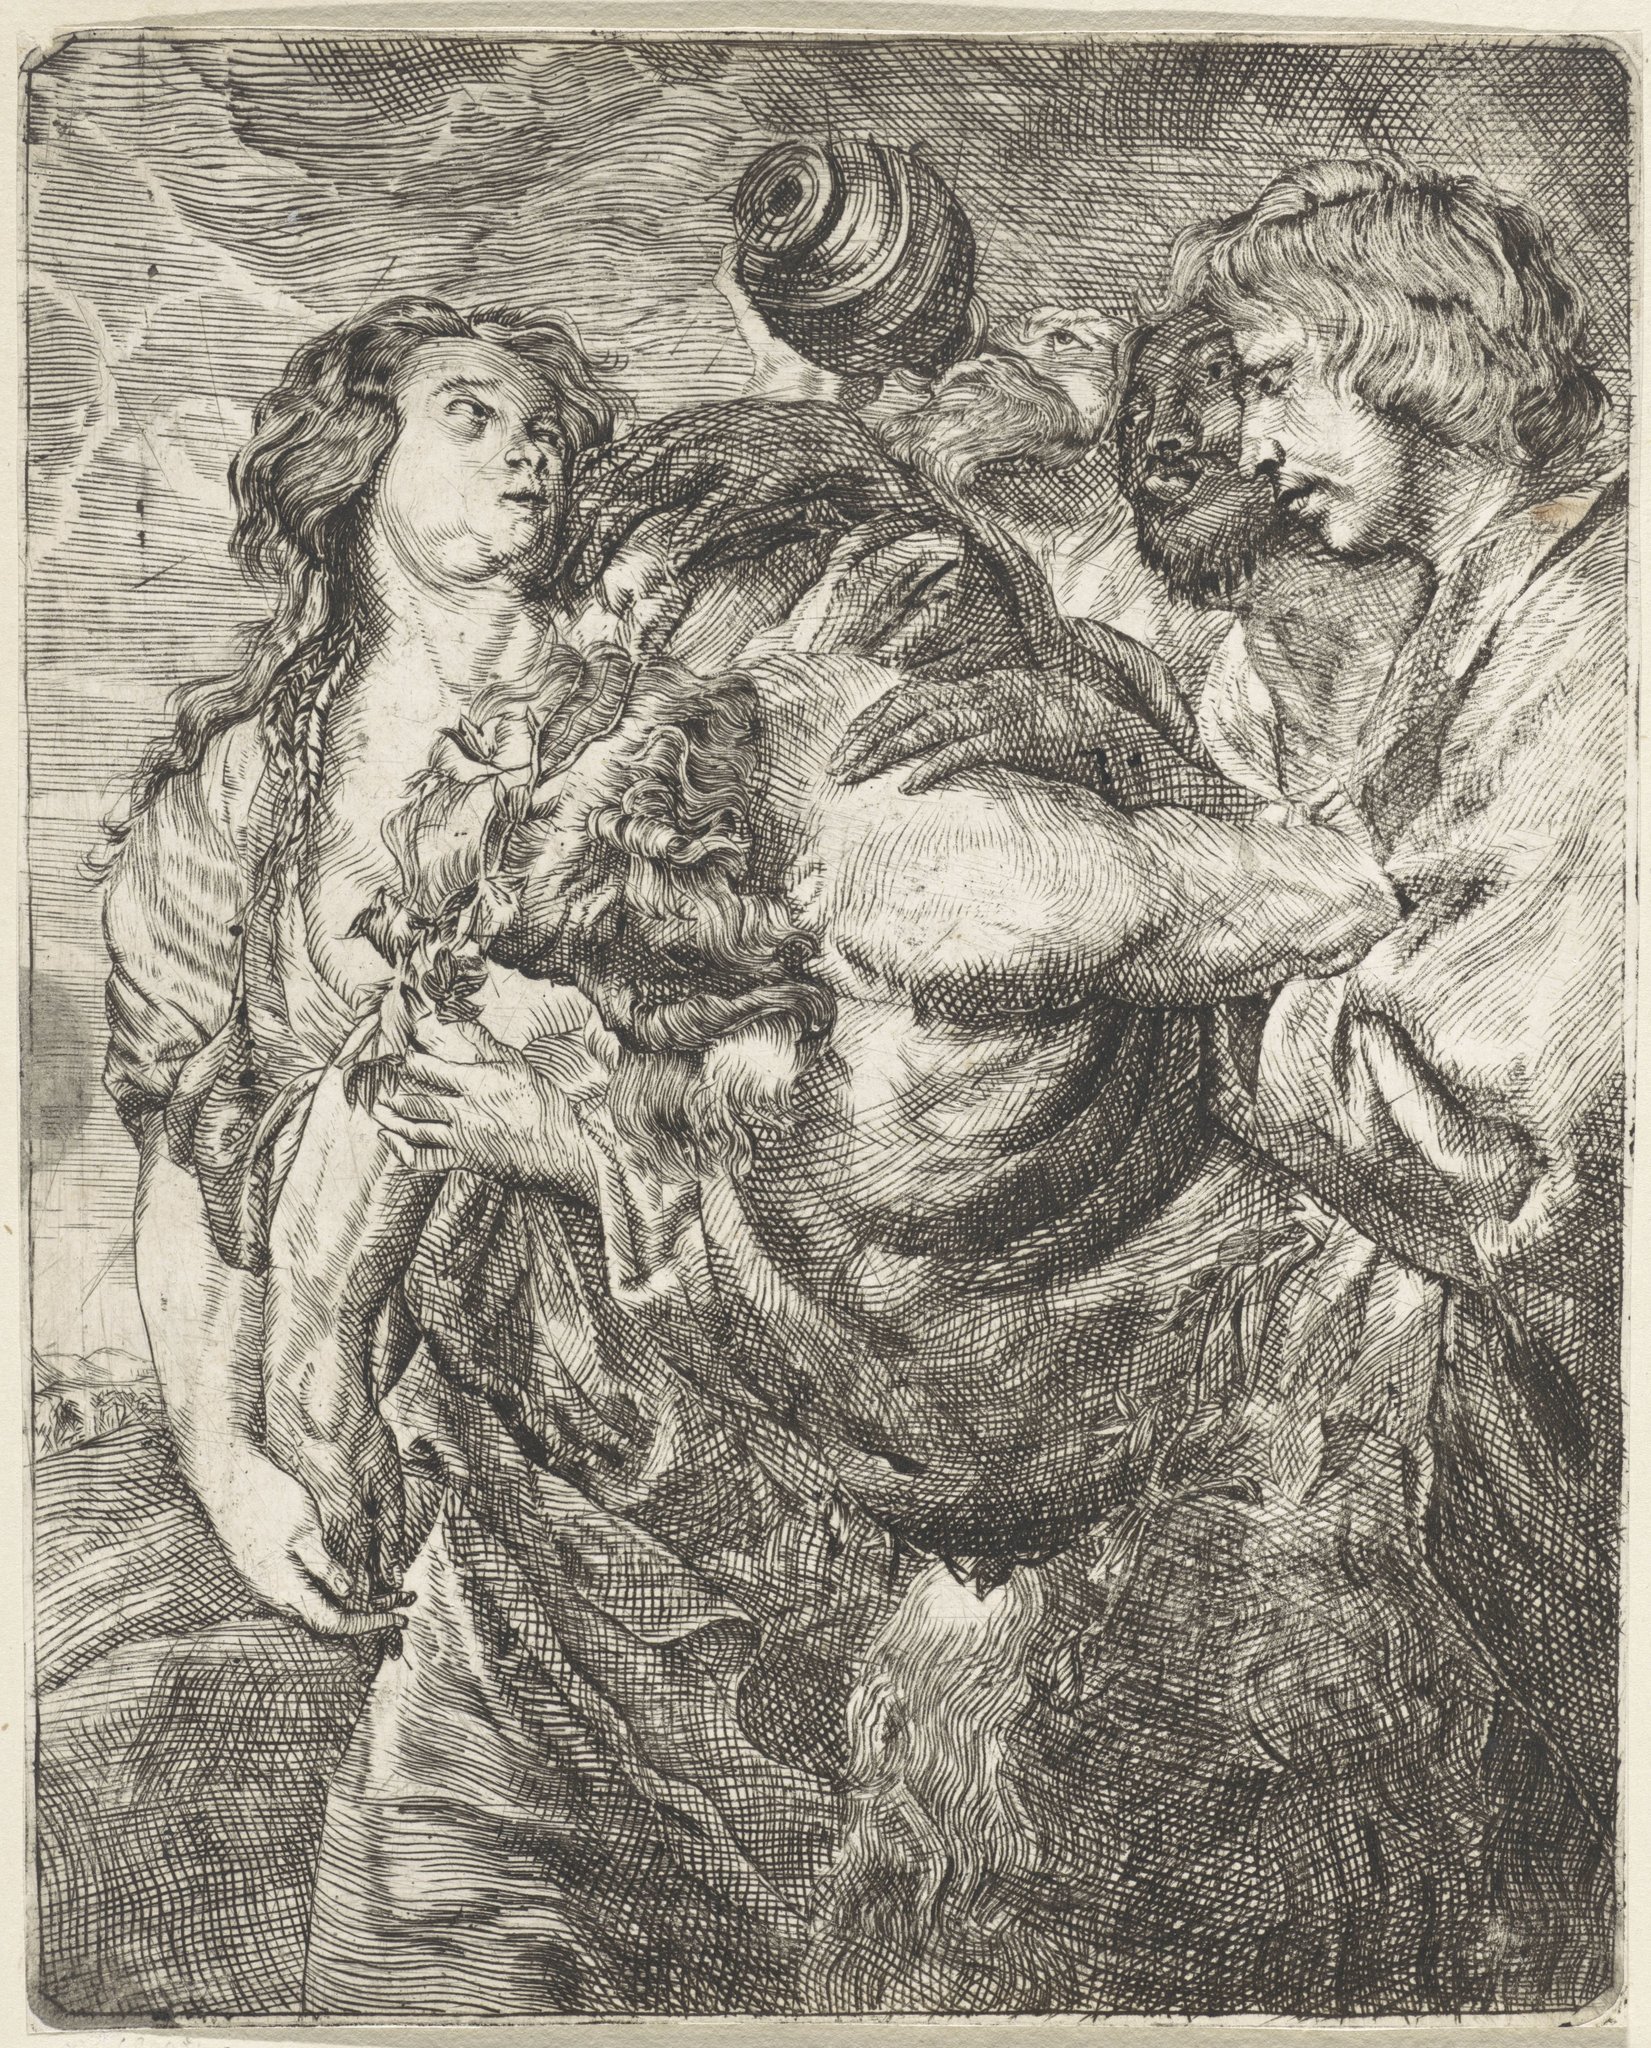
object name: print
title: Dronken Silenus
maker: Anonymous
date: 1615-1691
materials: paper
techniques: engraving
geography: low countries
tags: (story of) silenus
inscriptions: collector's mark: Lugt 240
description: De dronken Silenus staat voorovergebogen. In zijn haar heeft hij klimop. Hij wordt ondersteund door een maenade en enkele mannelijke volgelingen van Bacchus. Eén van hen drinkt uit een kruik.